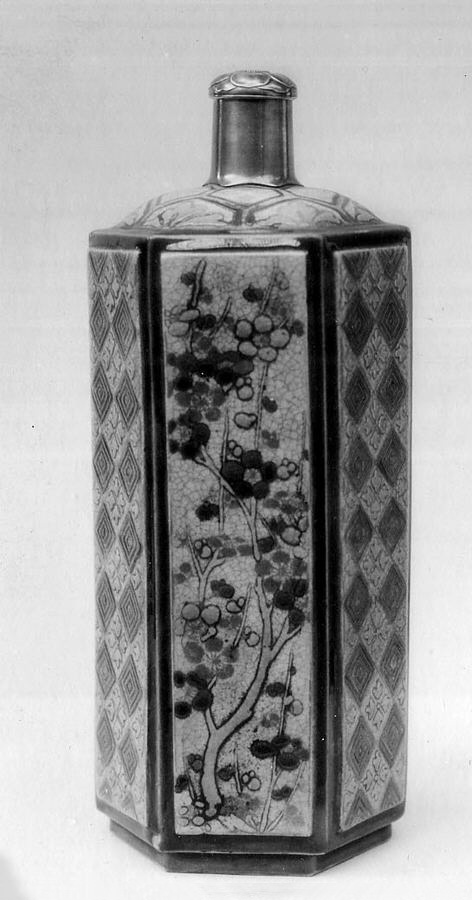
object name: wine bottle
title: Hexagonal Wine Bottle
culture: japanese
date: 1720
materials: enamel, faience, glaze, gold, pottery, silver